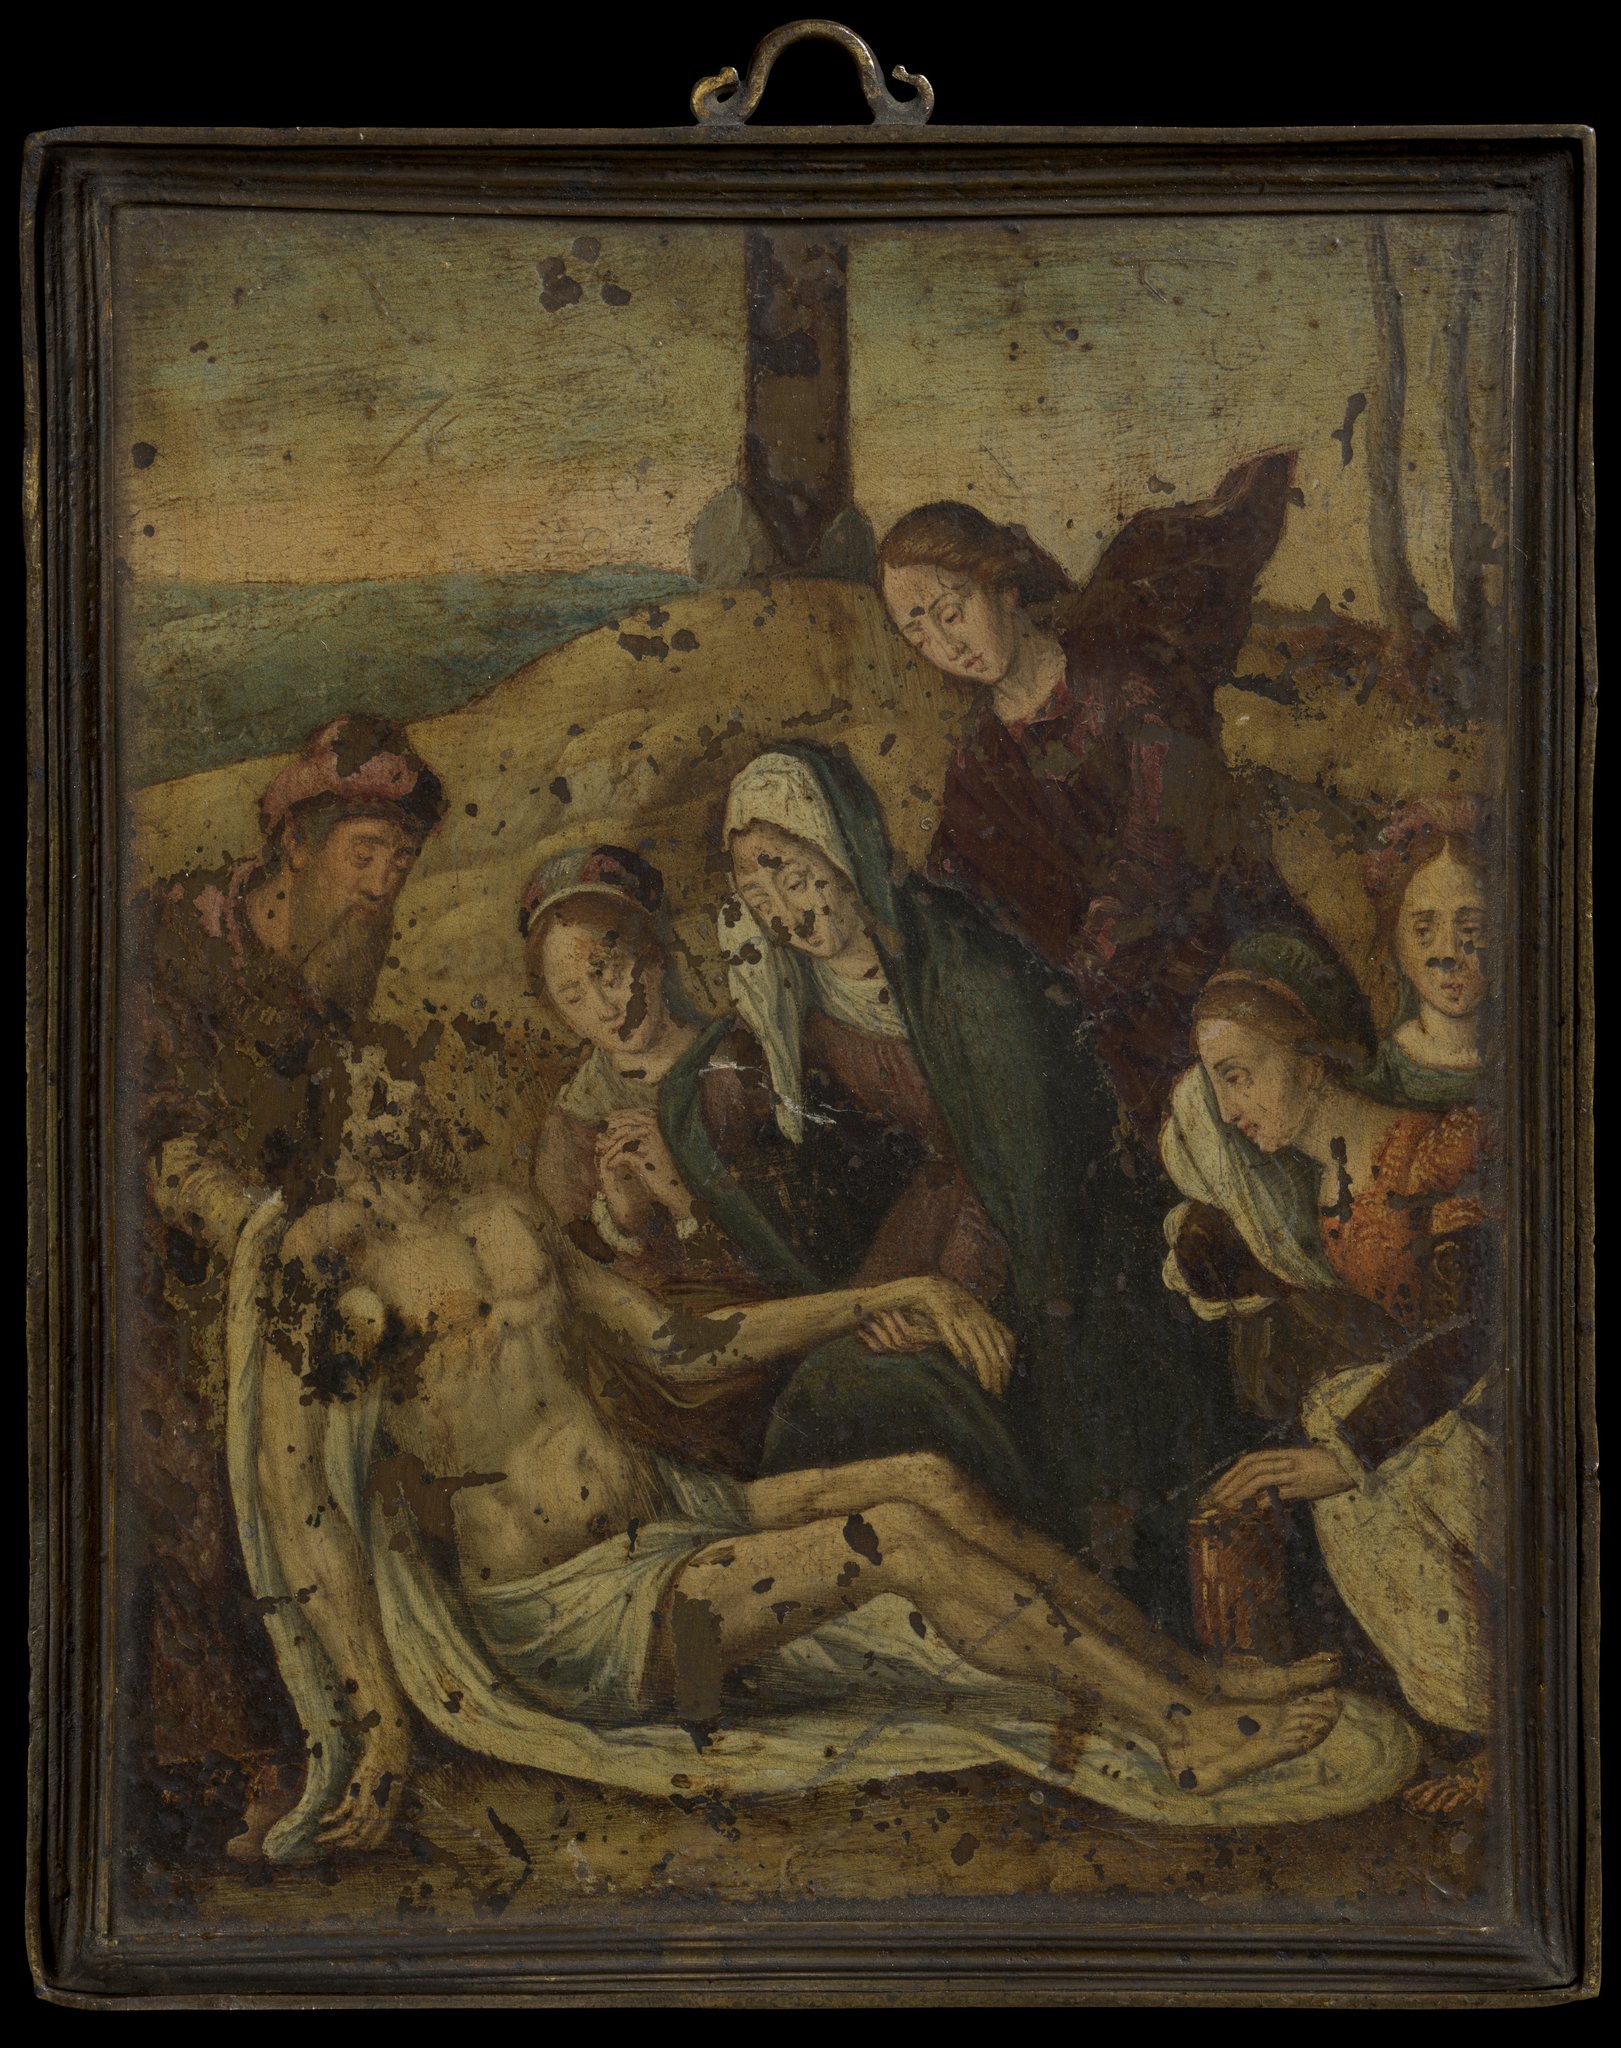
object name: painting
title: The Lamentation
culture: dutch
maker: netherlandish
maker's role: artist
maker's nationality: netherlandish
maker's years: 1545-1555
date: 1550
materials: copper alloy, oil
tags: christ,virgin mary,lamentation